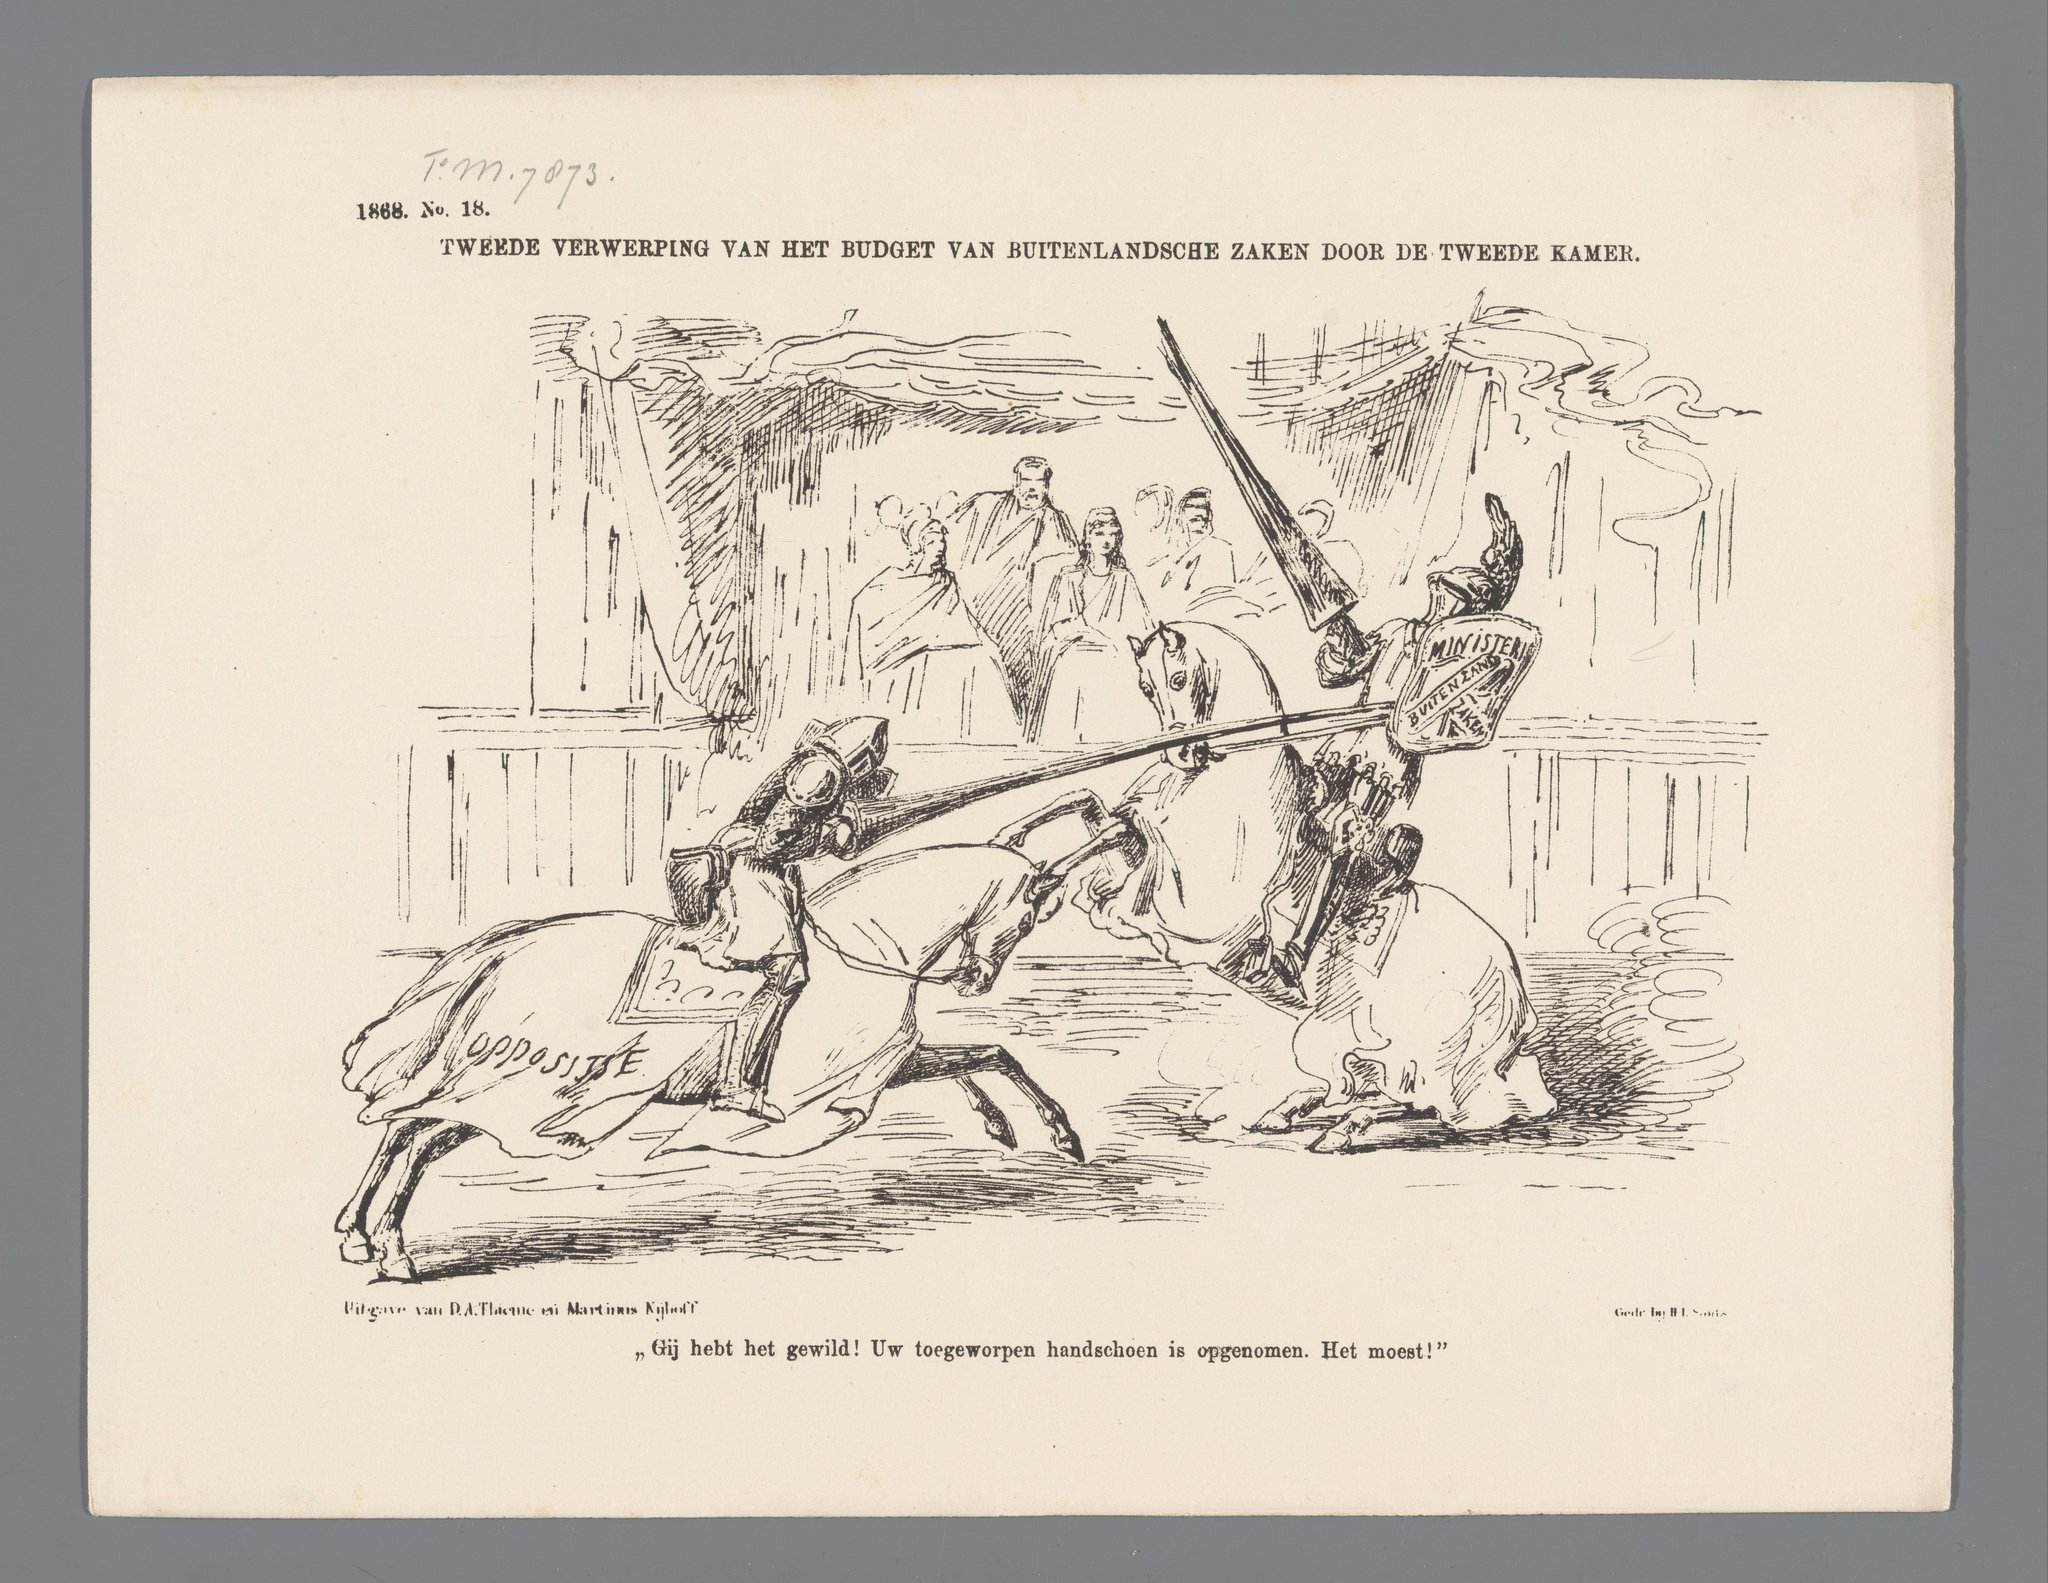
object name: cartoon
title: Spotprent op de verwerping van het budget van minister Van Zuylen, 1868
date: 1867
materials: paper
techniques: lithograph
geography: arnhem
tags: earl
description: Spotprent op de verwerping van het budget van minister Van Zuylen van Buitenlandse Zaken. Voorgesteld als een steekspel tussen het ministerie en de oppositie. Plaat verschenen bij het weekblad De Nederlandsche Spectator, nr. 18, 2 mei 1868.